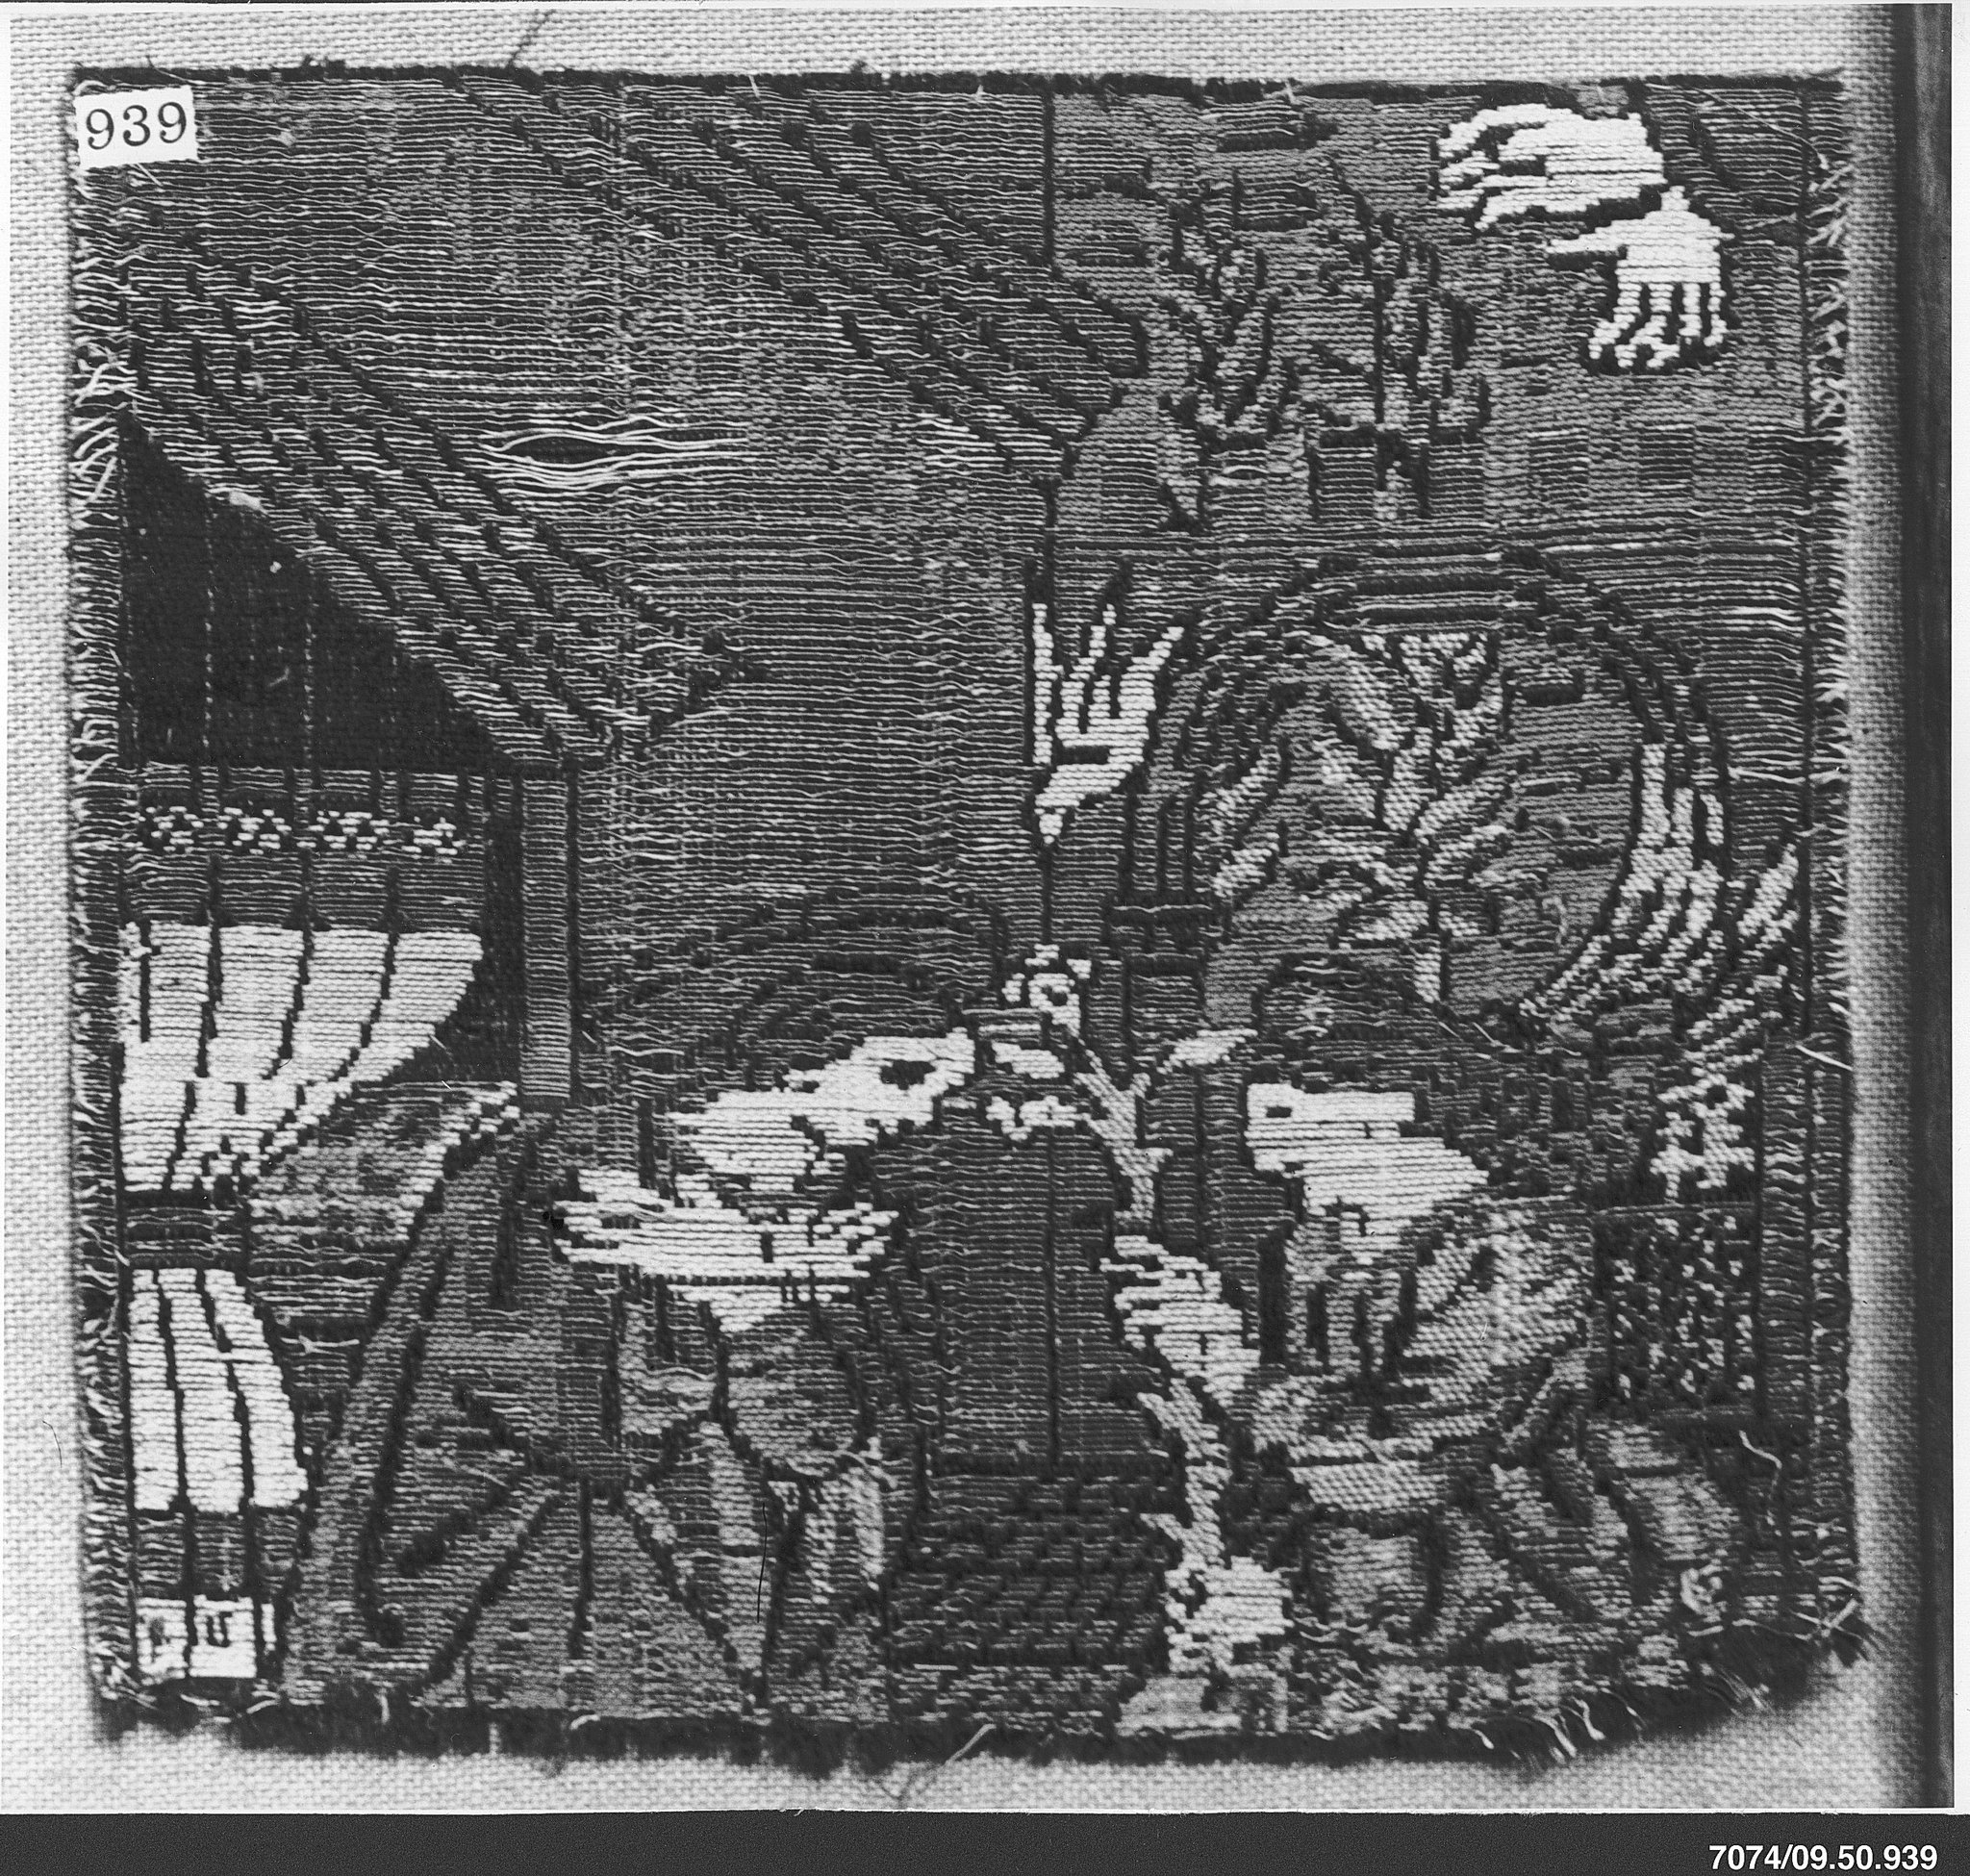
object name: orphrey fragment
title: Fragment of orphrey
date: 1401-1500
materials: linen, metal thread, silk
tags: birds,hands,women